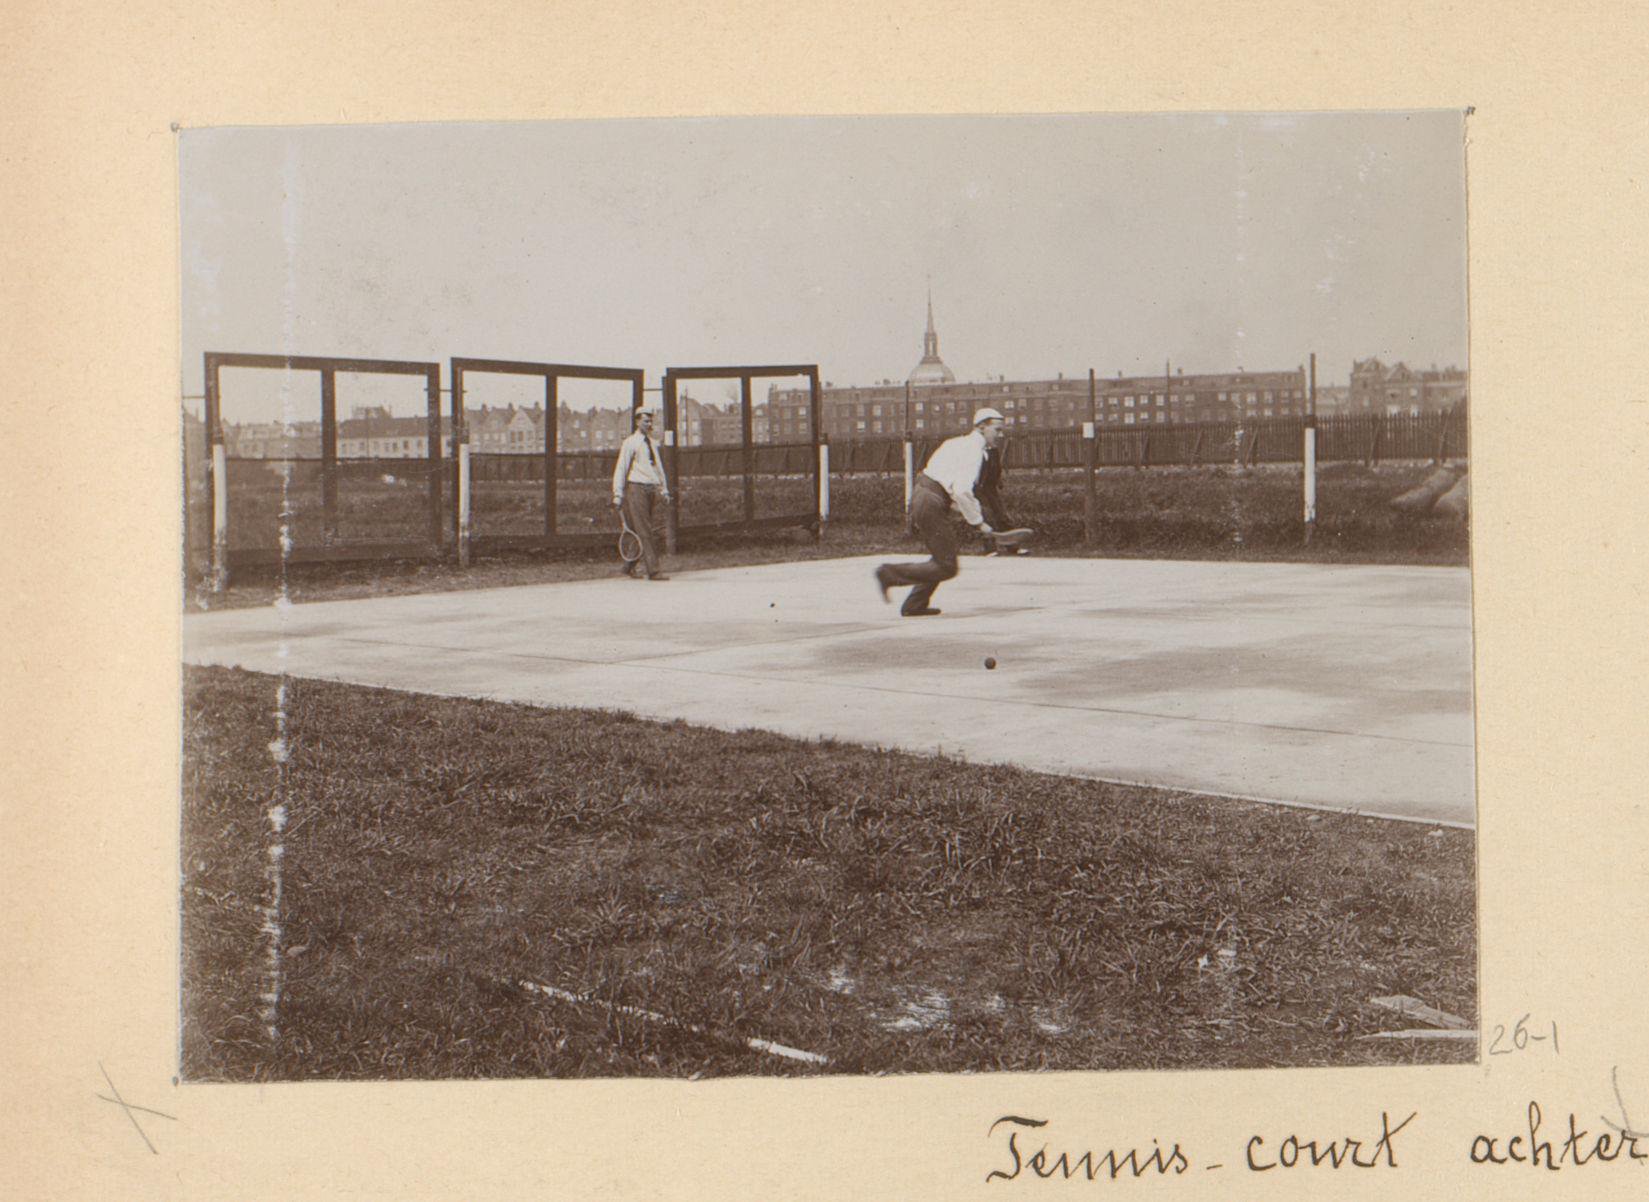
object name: photograph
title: Page from the Album of the Photographer: Tennis Court behind the Rijksmuseum, Amsterdam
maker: hendrik herman van den berg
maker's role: amateurfotograaf, jurist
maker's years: 1875-1944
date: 1890-1894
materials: paper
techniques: collodion silver print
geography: amsterdam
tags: tennis, lawn-tennis, amsterdam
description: Foto 1 op albumblad 26 uit album "Amsterdam 1890-1894".